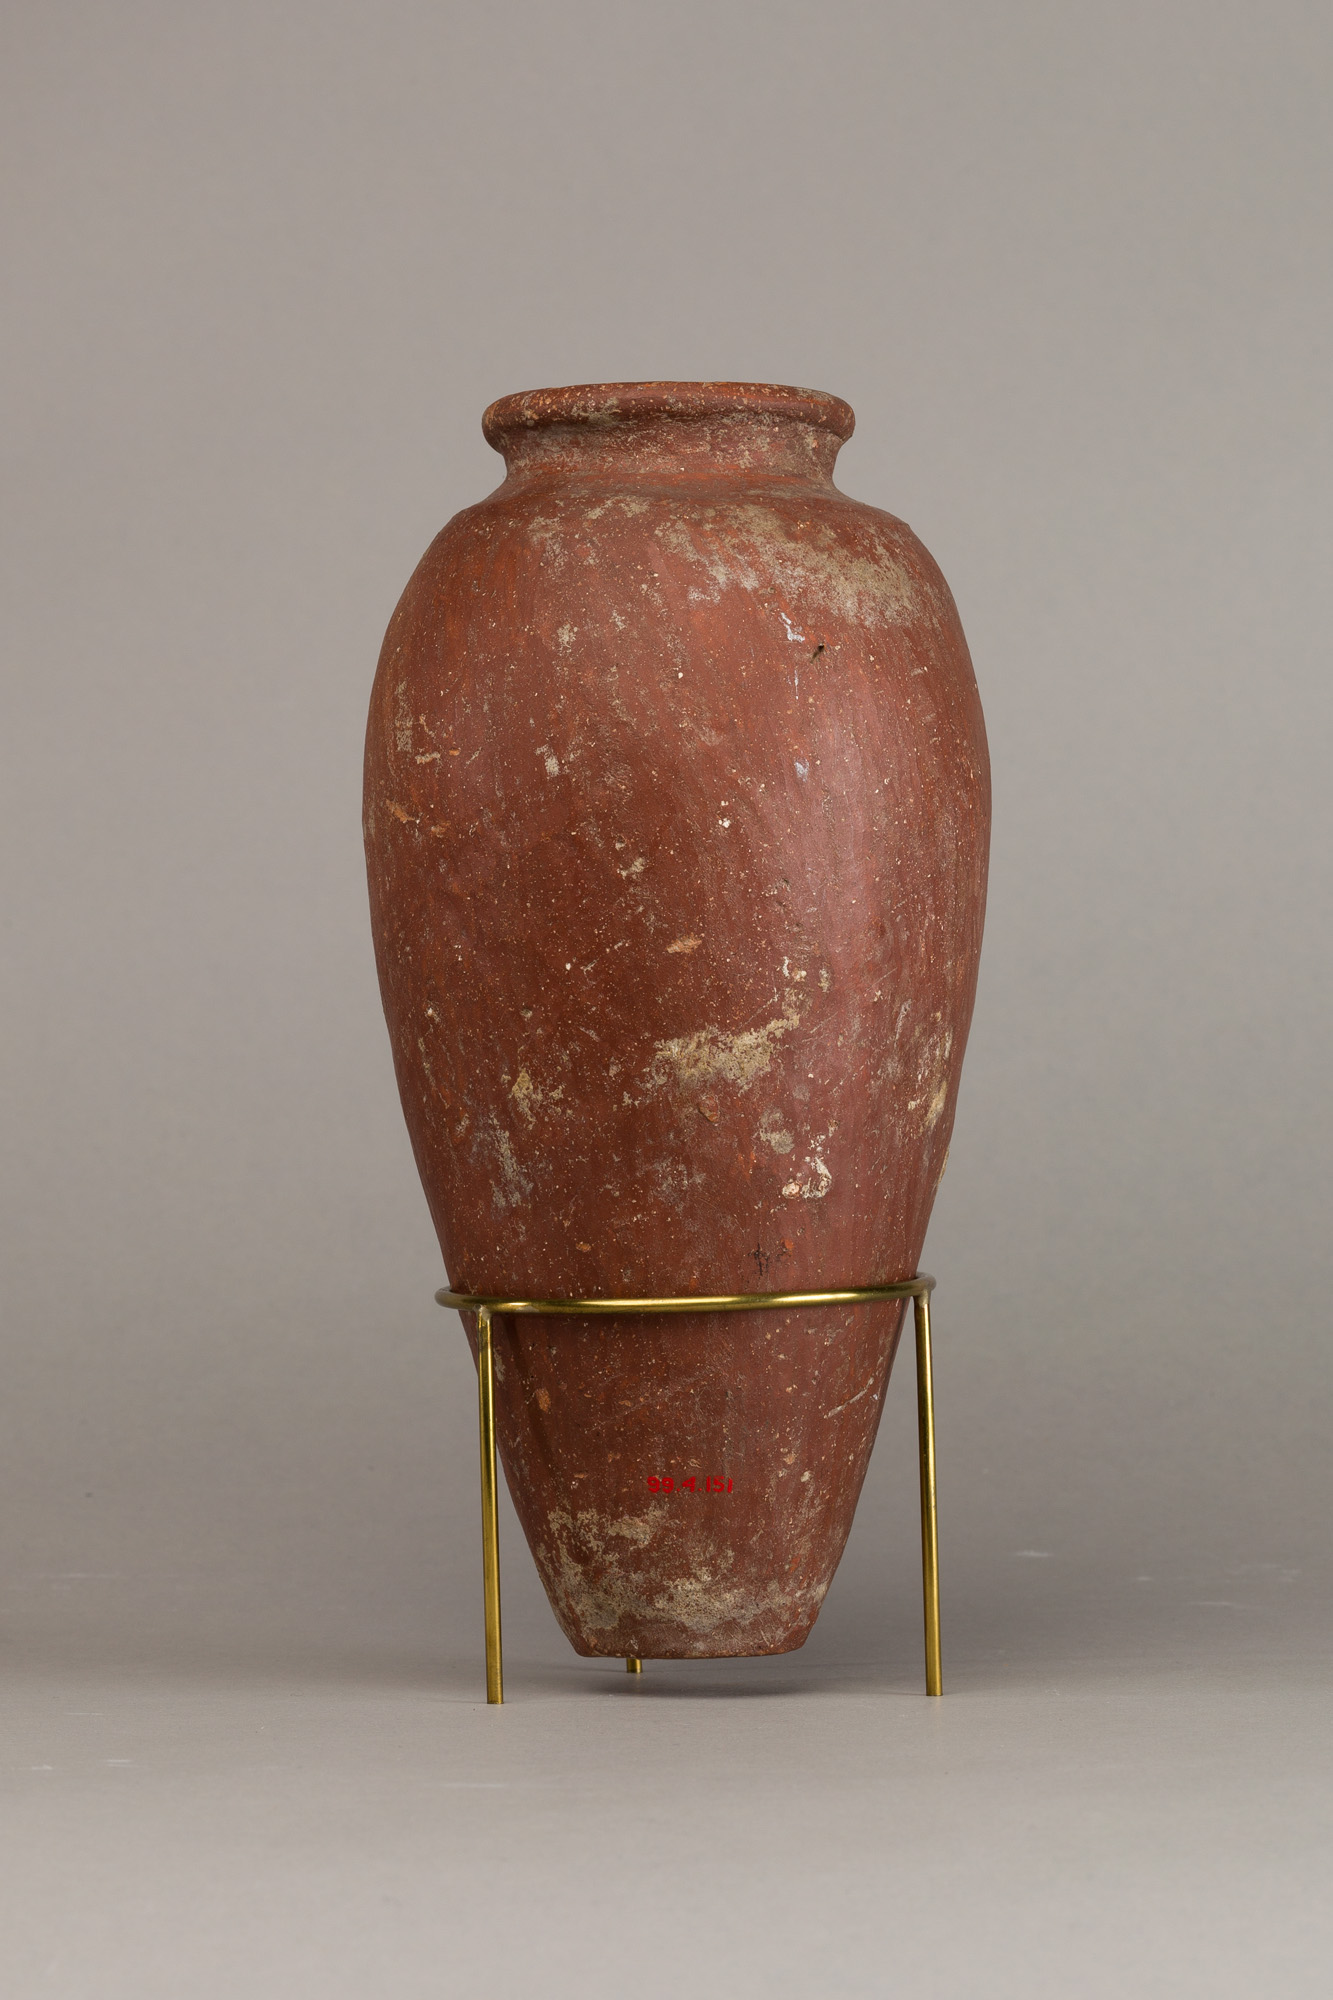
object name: jar, red polished ware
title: Large red polished ware jar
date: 3850-2960 BCE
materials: pottery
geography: northern upper egypt